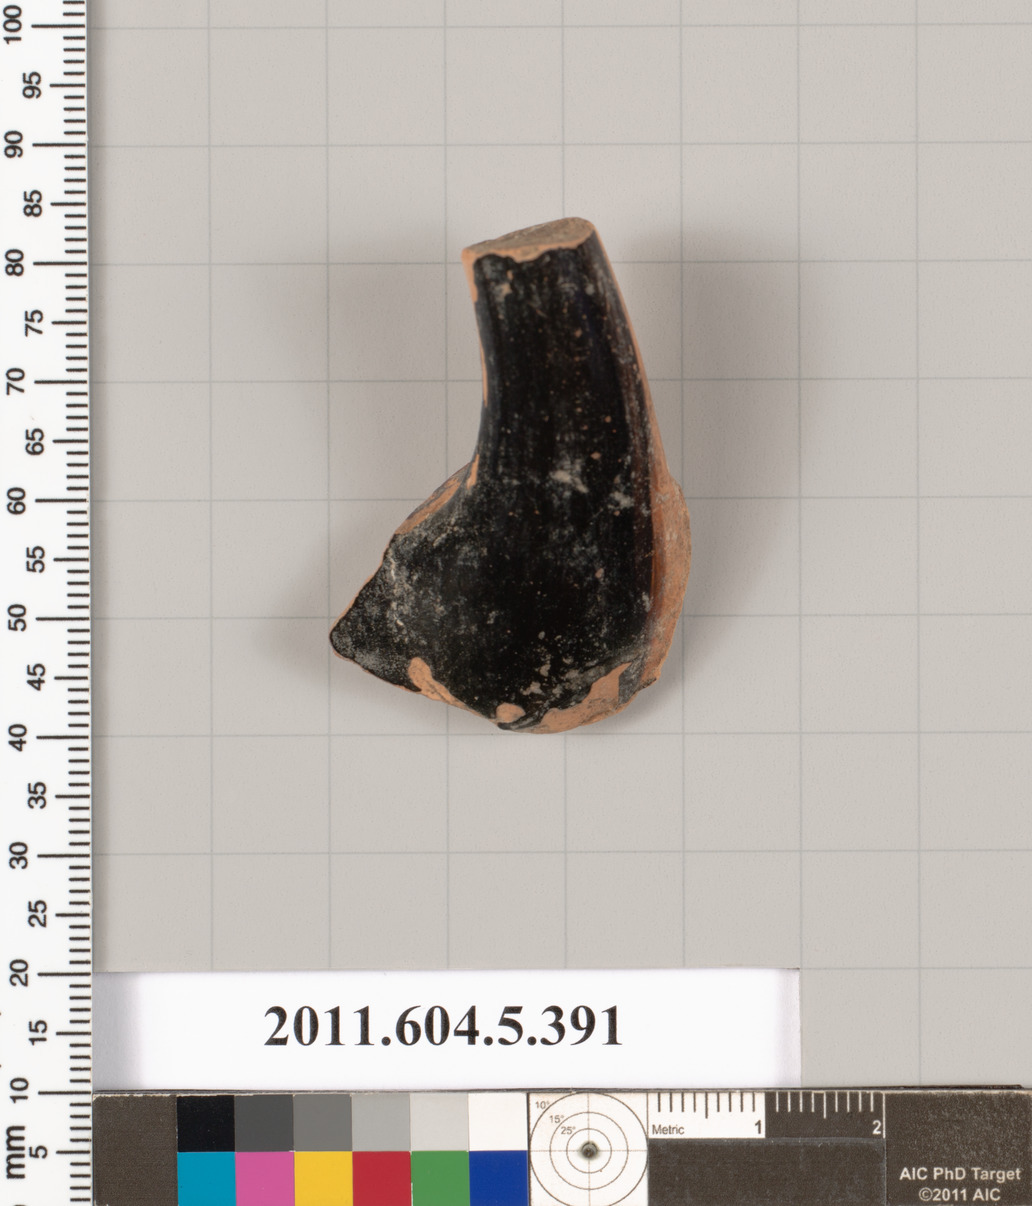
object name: kylix fragment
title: Terracotta fragment of a kylix (drinking cup)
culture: greek, attic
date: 600-401 BCE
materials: terracotta